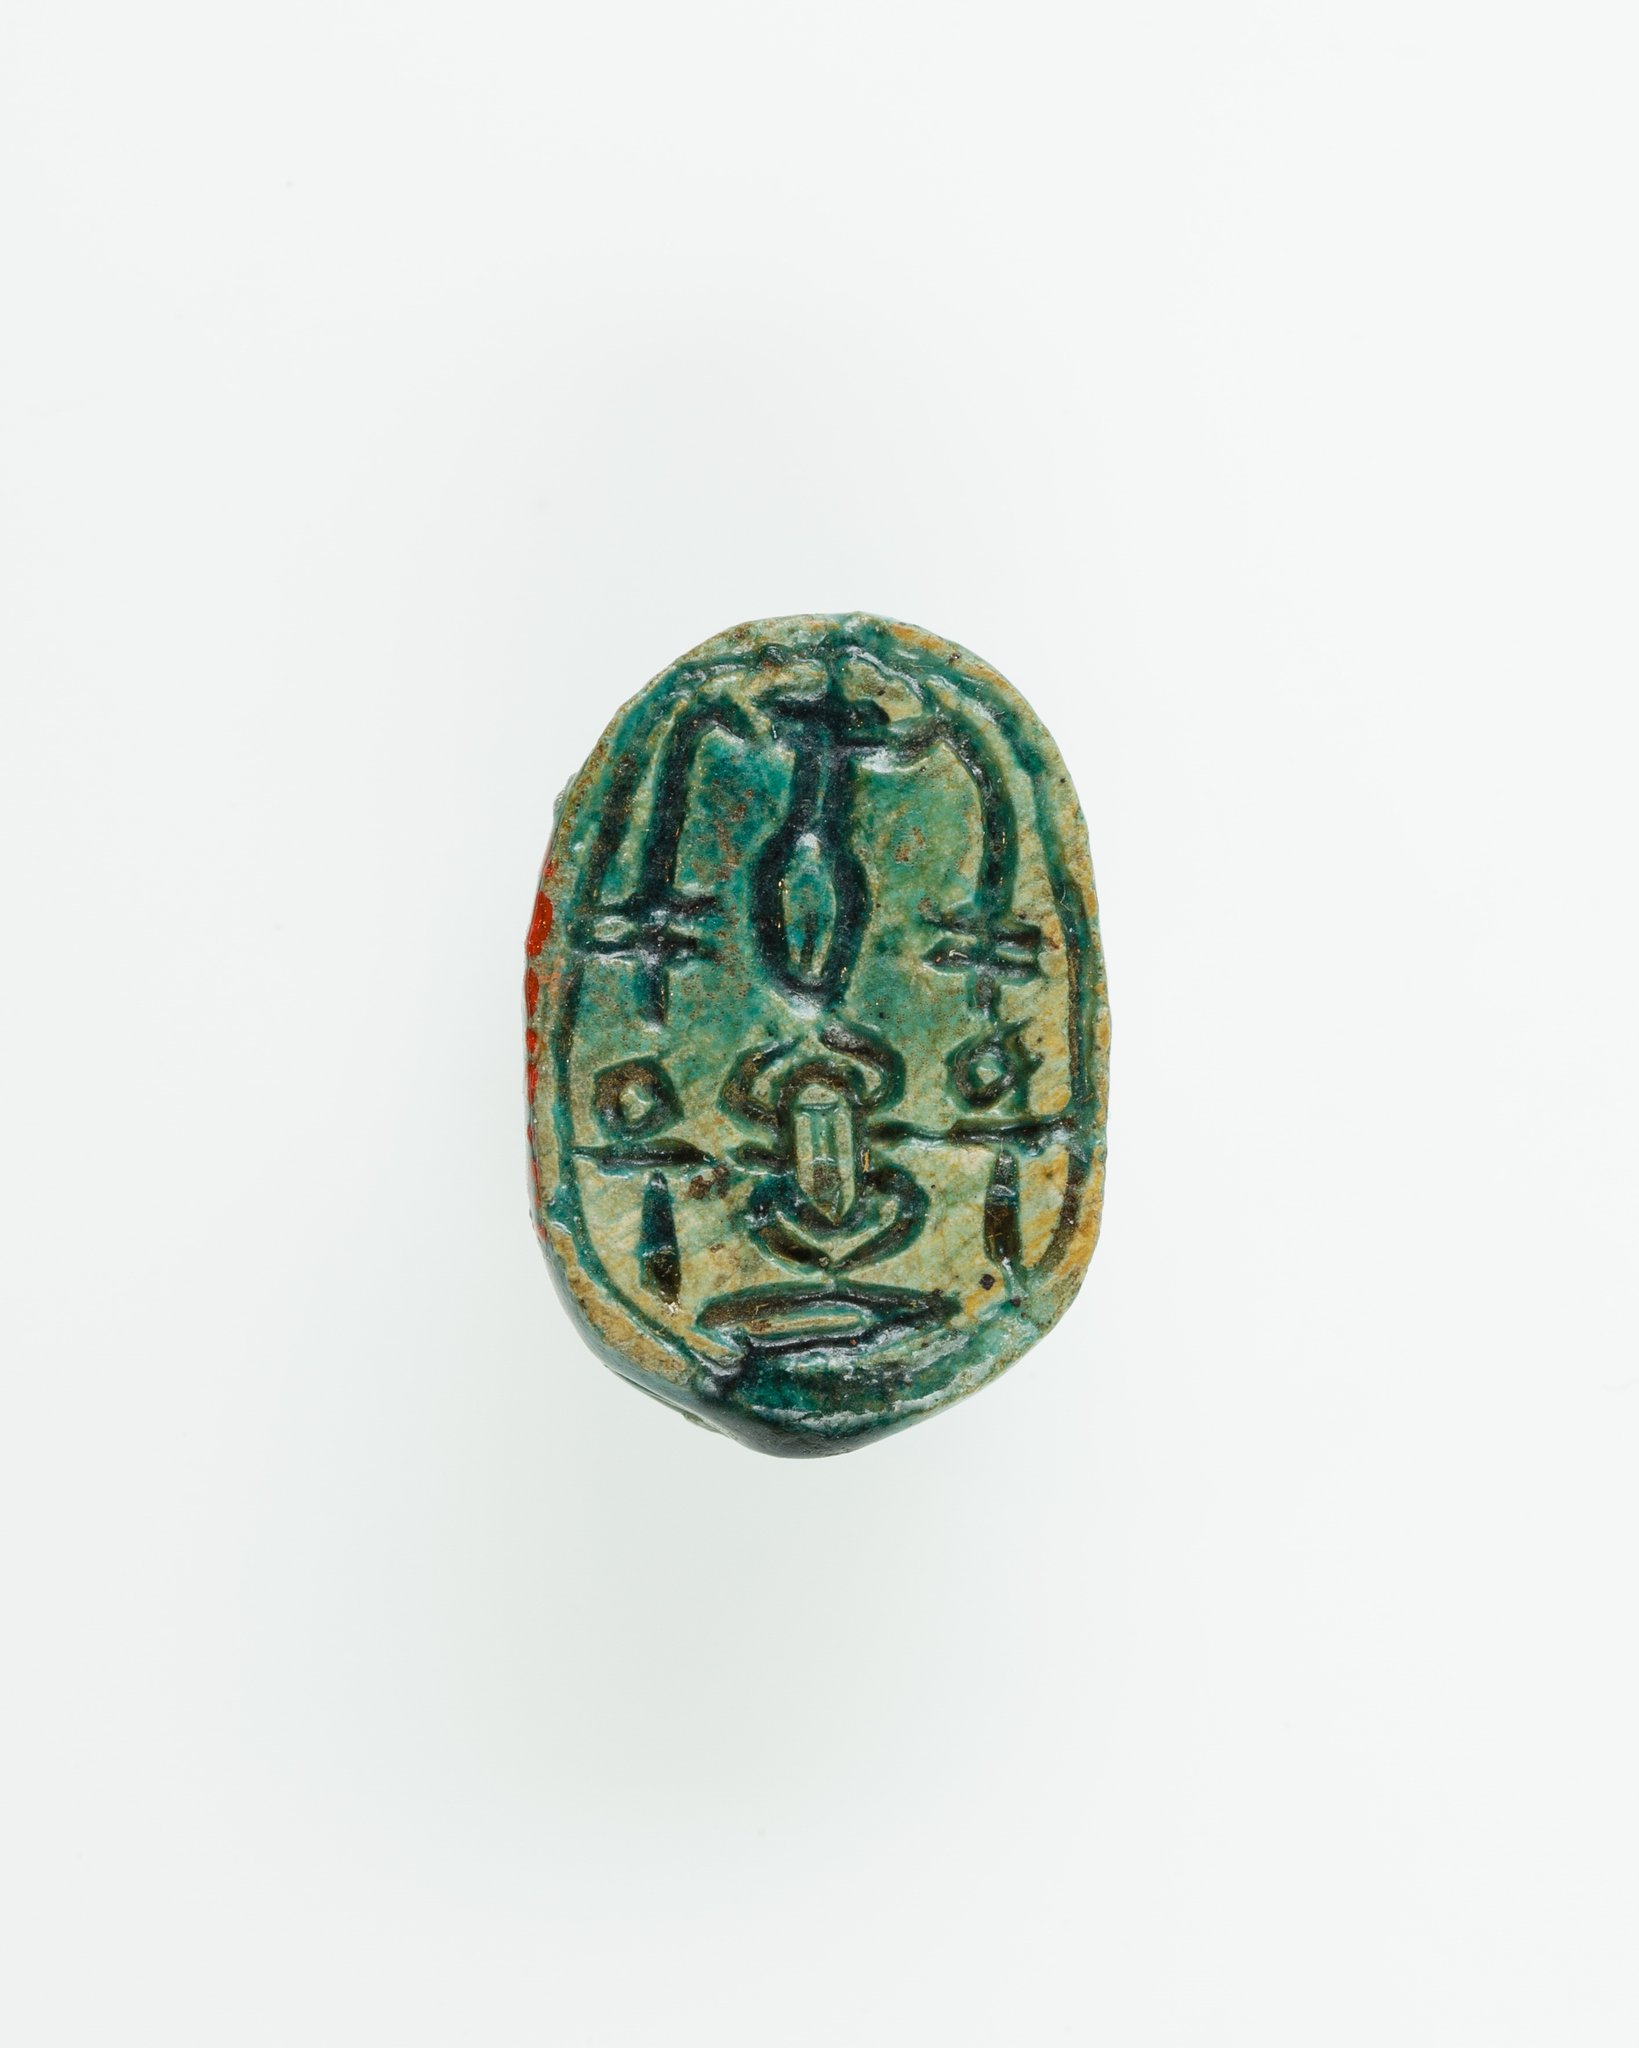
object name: scarab, hieroglyph, ankh, sa, nefer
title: Scarab Inscribed with Hieroglyphs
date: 1640-1550 BCE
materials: stone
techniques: glazing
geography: egypt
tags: scarabs